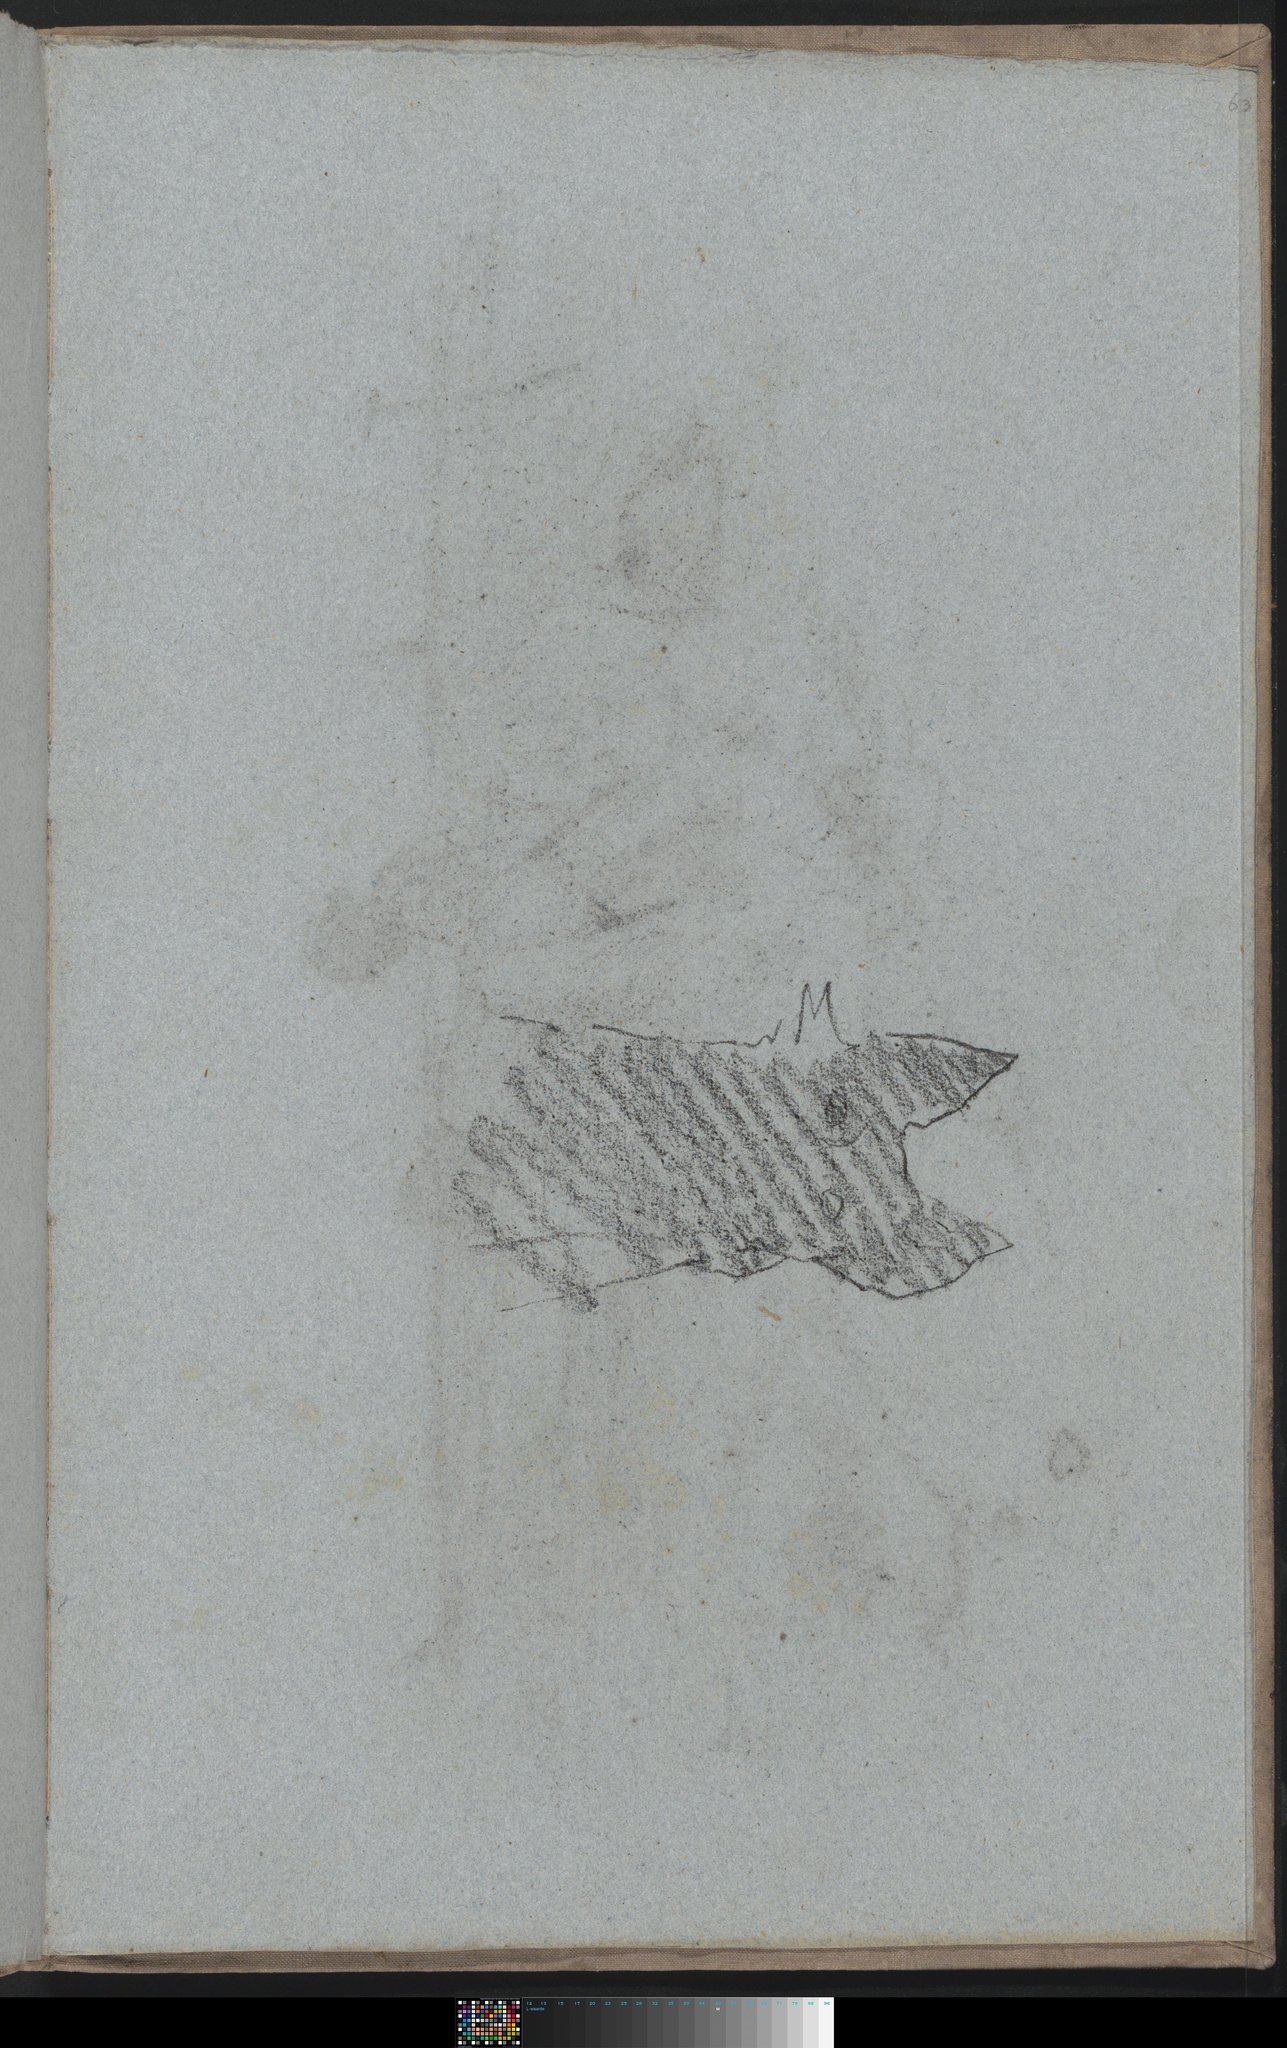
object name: sketchbook leaf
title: Kop van een hond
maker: willem witsen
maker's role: draughtsman, painter, print maker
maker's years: 1860-1923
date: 1886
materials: chalk, paper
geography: ewijkshoeve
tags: dog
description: Pagina 63 uit een schetsboek met 38 bladen betekend rond de Ewijkshoeve.